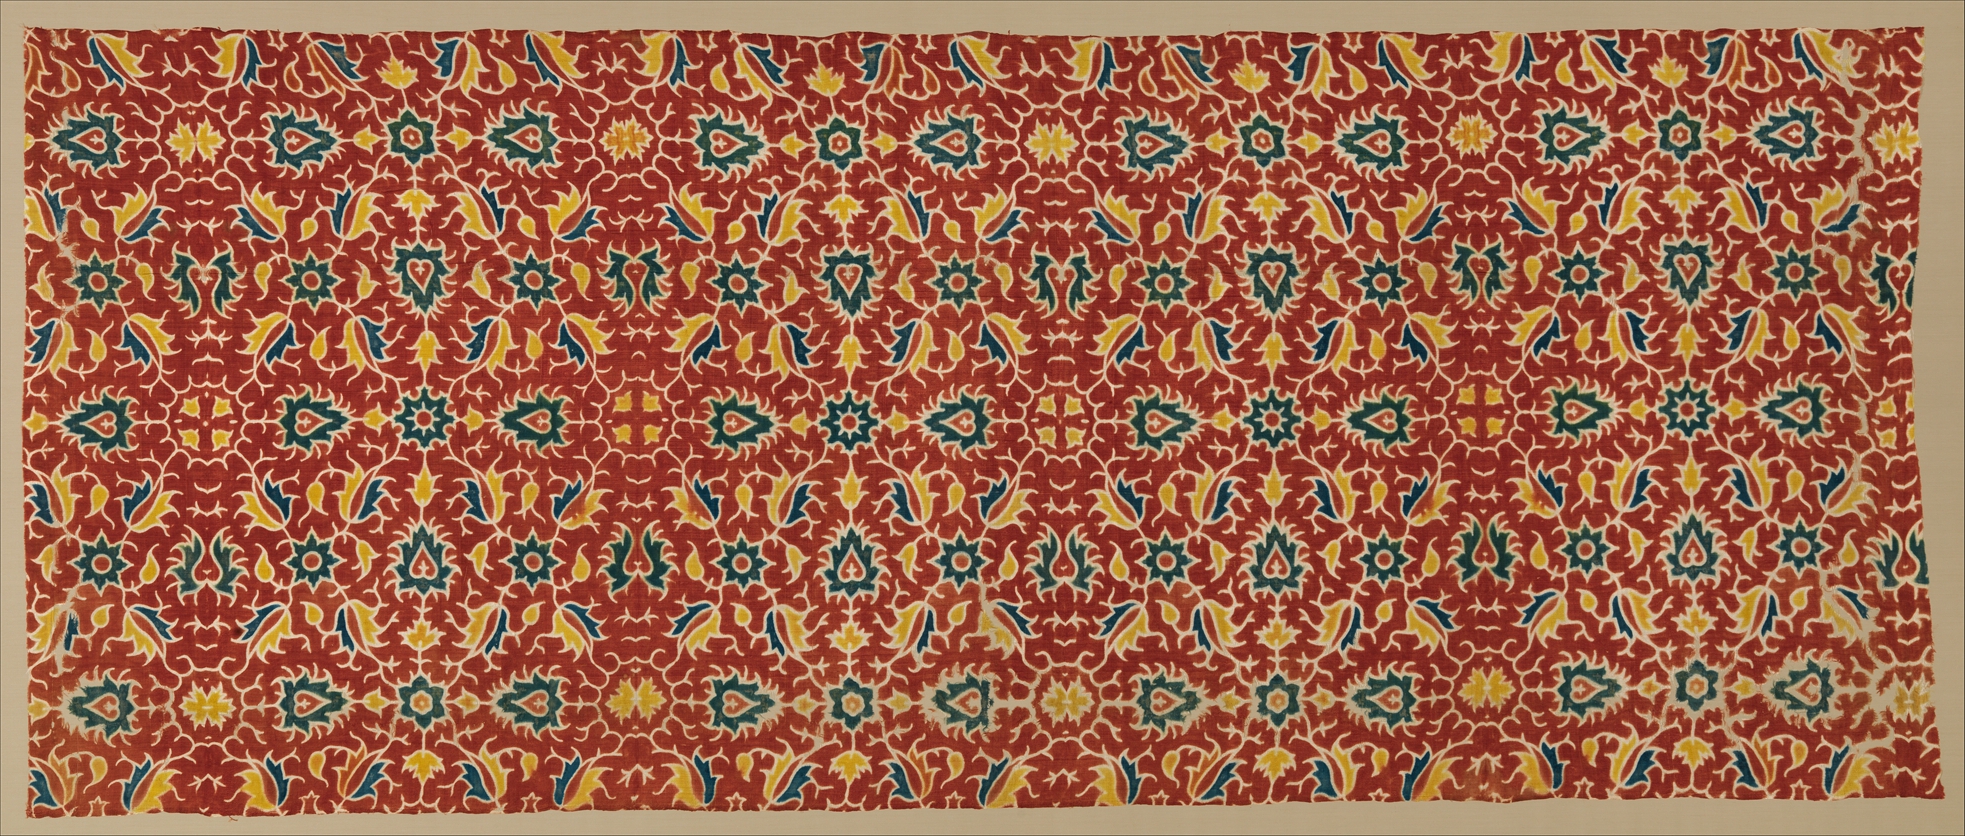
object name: lining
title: Dye-Patterned Silk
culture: indian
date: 1601-1700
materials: silk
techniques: dyeing, resist